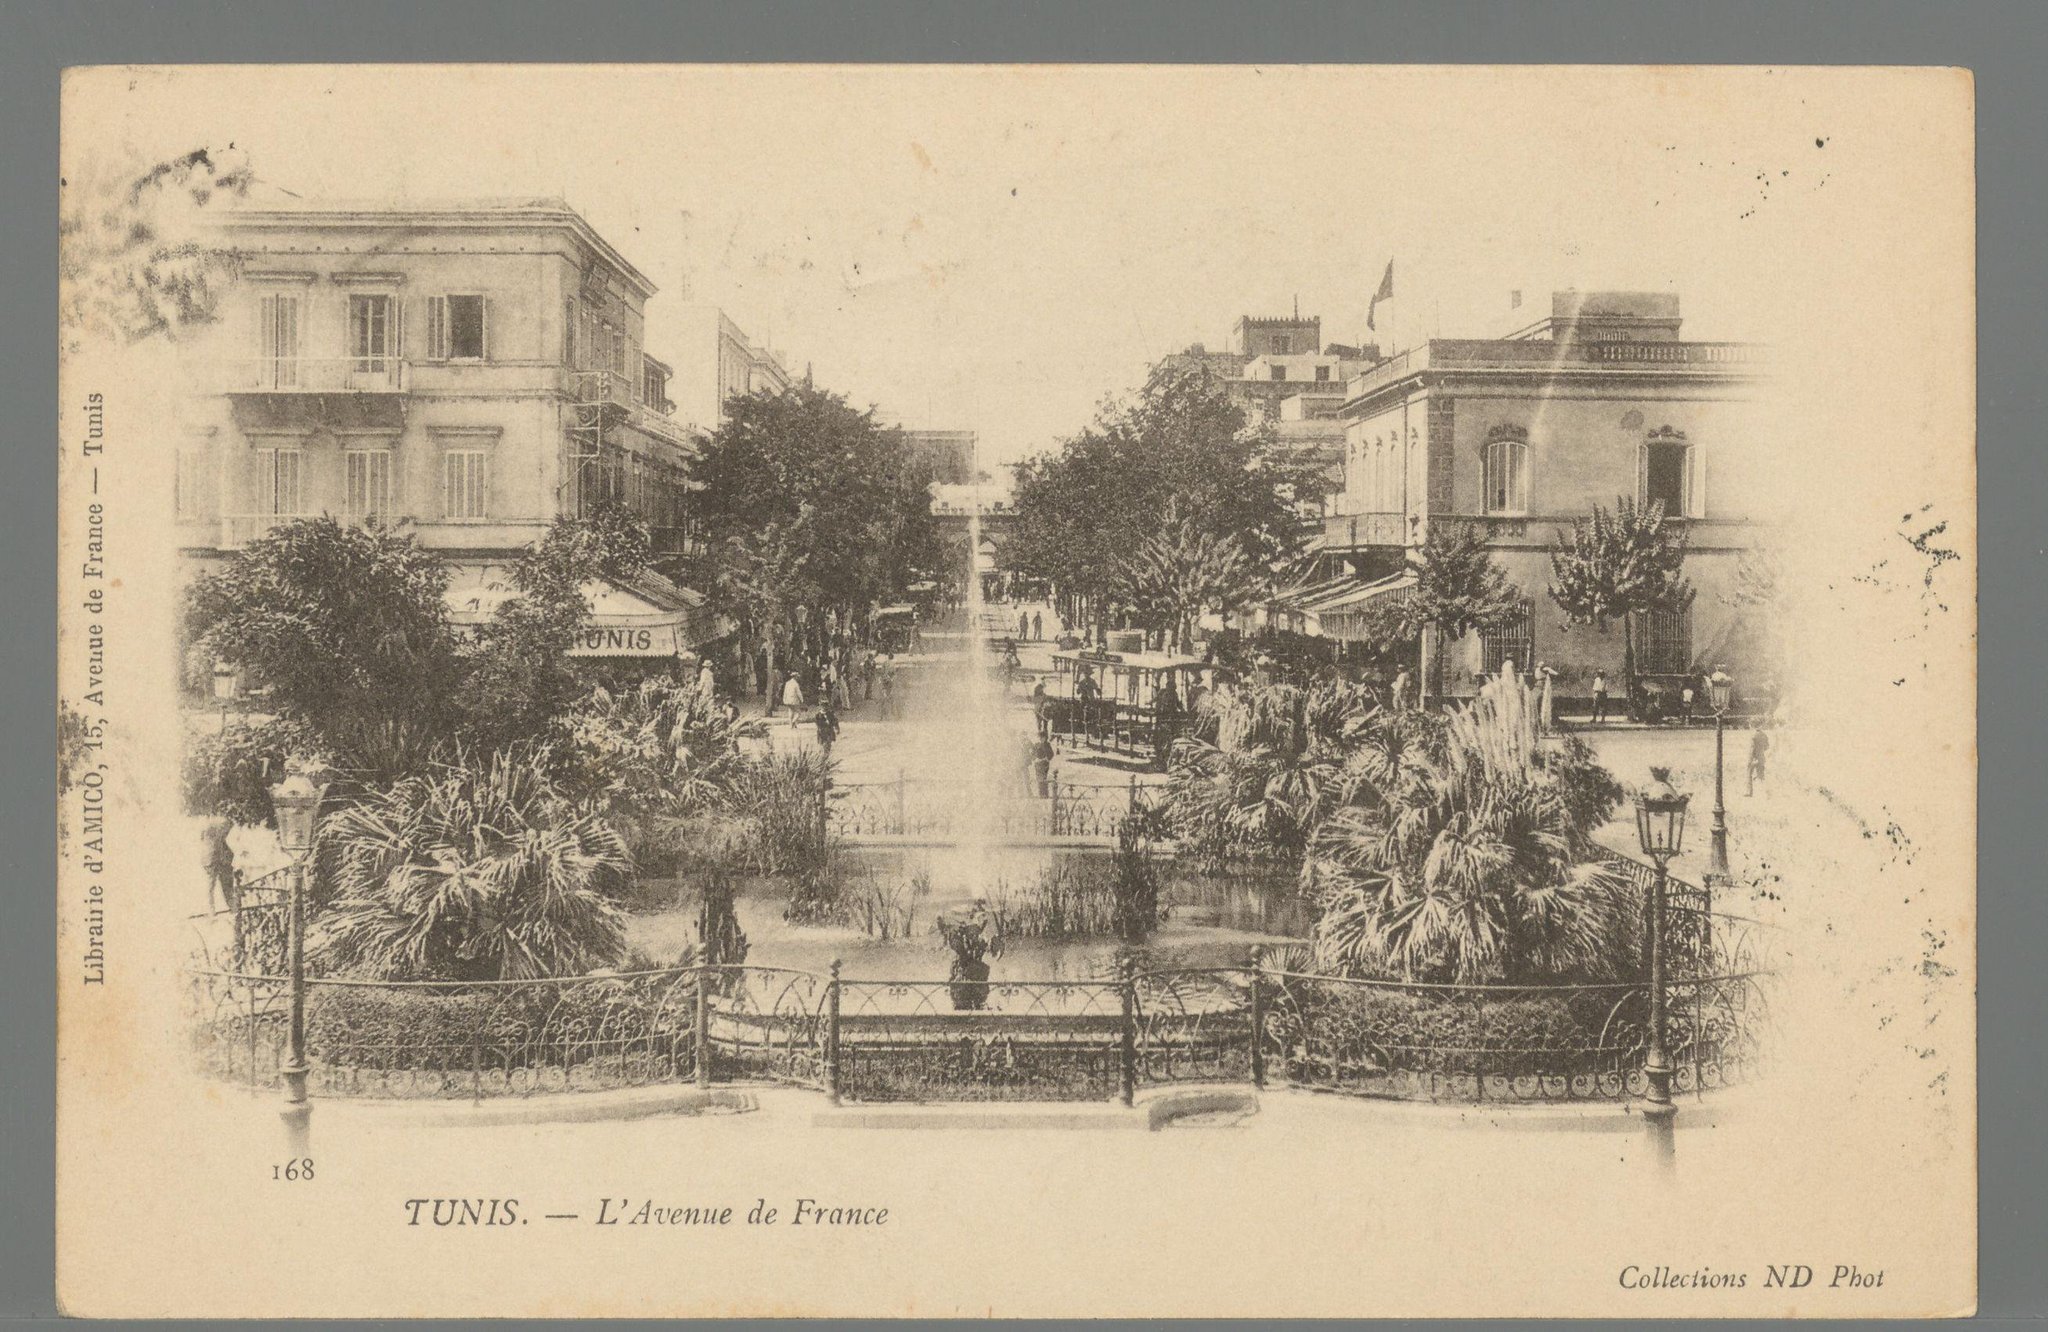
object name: photomechanical print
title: Tunis - L'Avenue de France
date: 1900-1903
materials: cardboard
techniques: photograph, writing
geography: tunis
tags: ornamental fountain, avenue, boulevard, promenade, esplanade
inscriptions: postage stamp